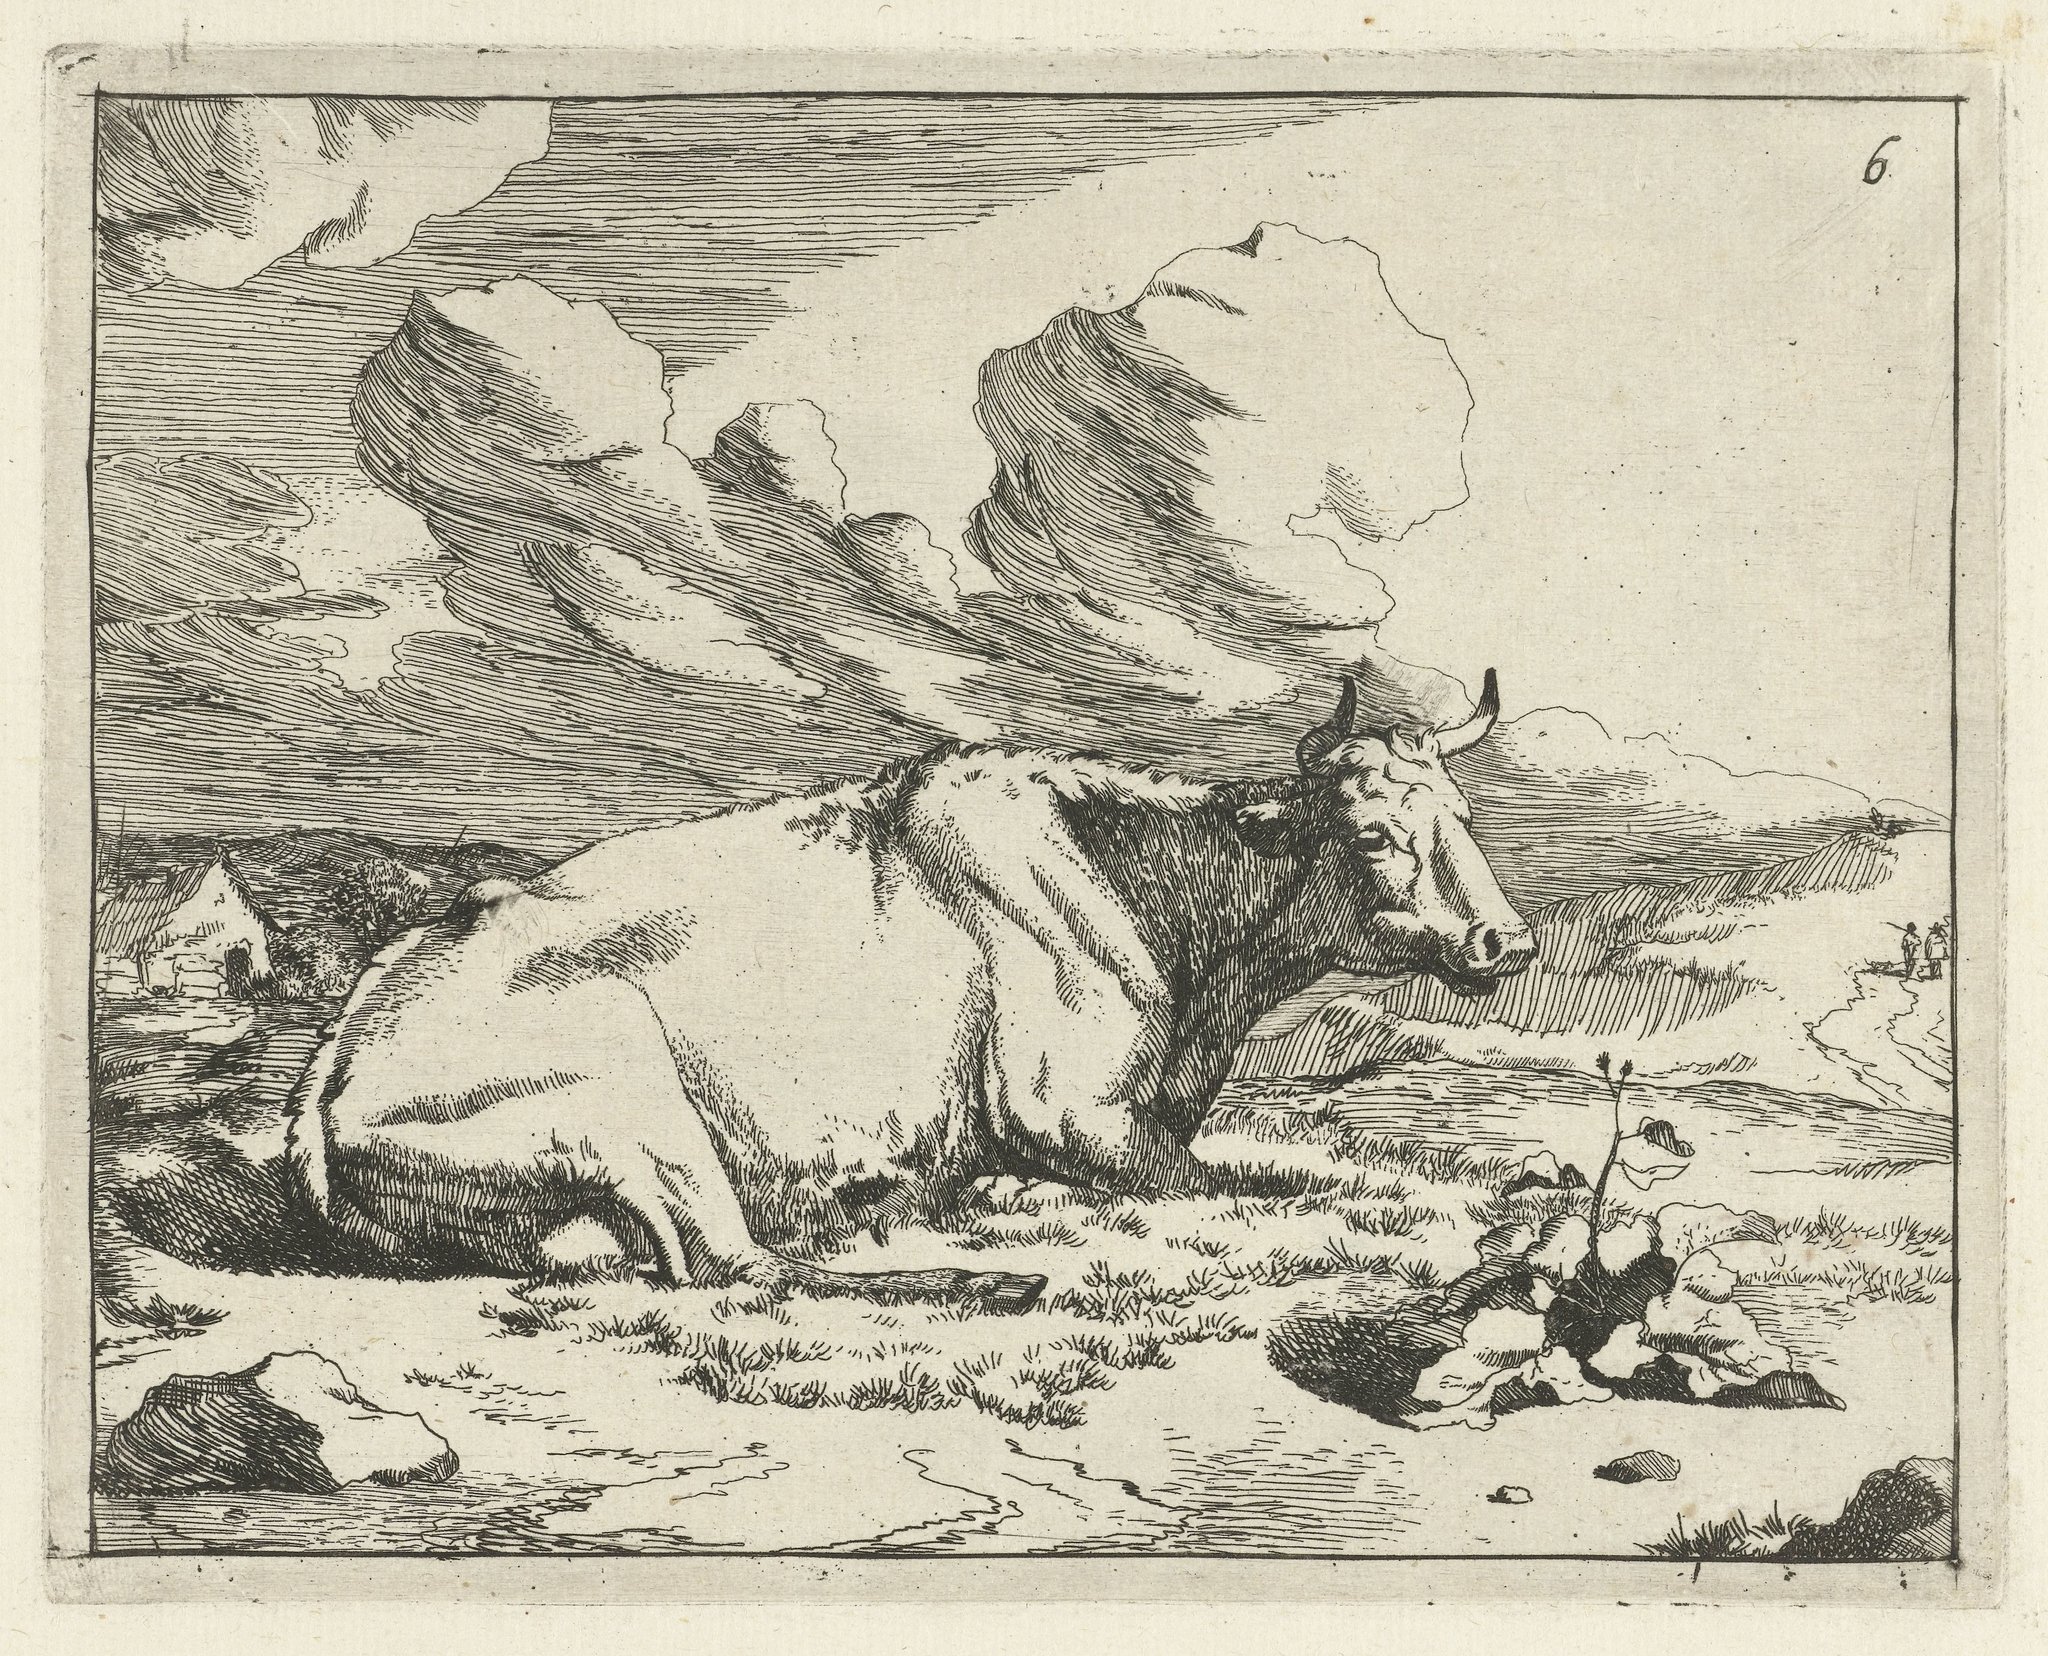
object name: print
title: Liggende koe, en profil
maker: marcus de bye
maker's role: print maker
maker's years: 1639-1688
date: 1657-1677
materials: paper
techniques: etching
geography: the hague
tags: cow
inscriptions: collector's mark: Lugt 240